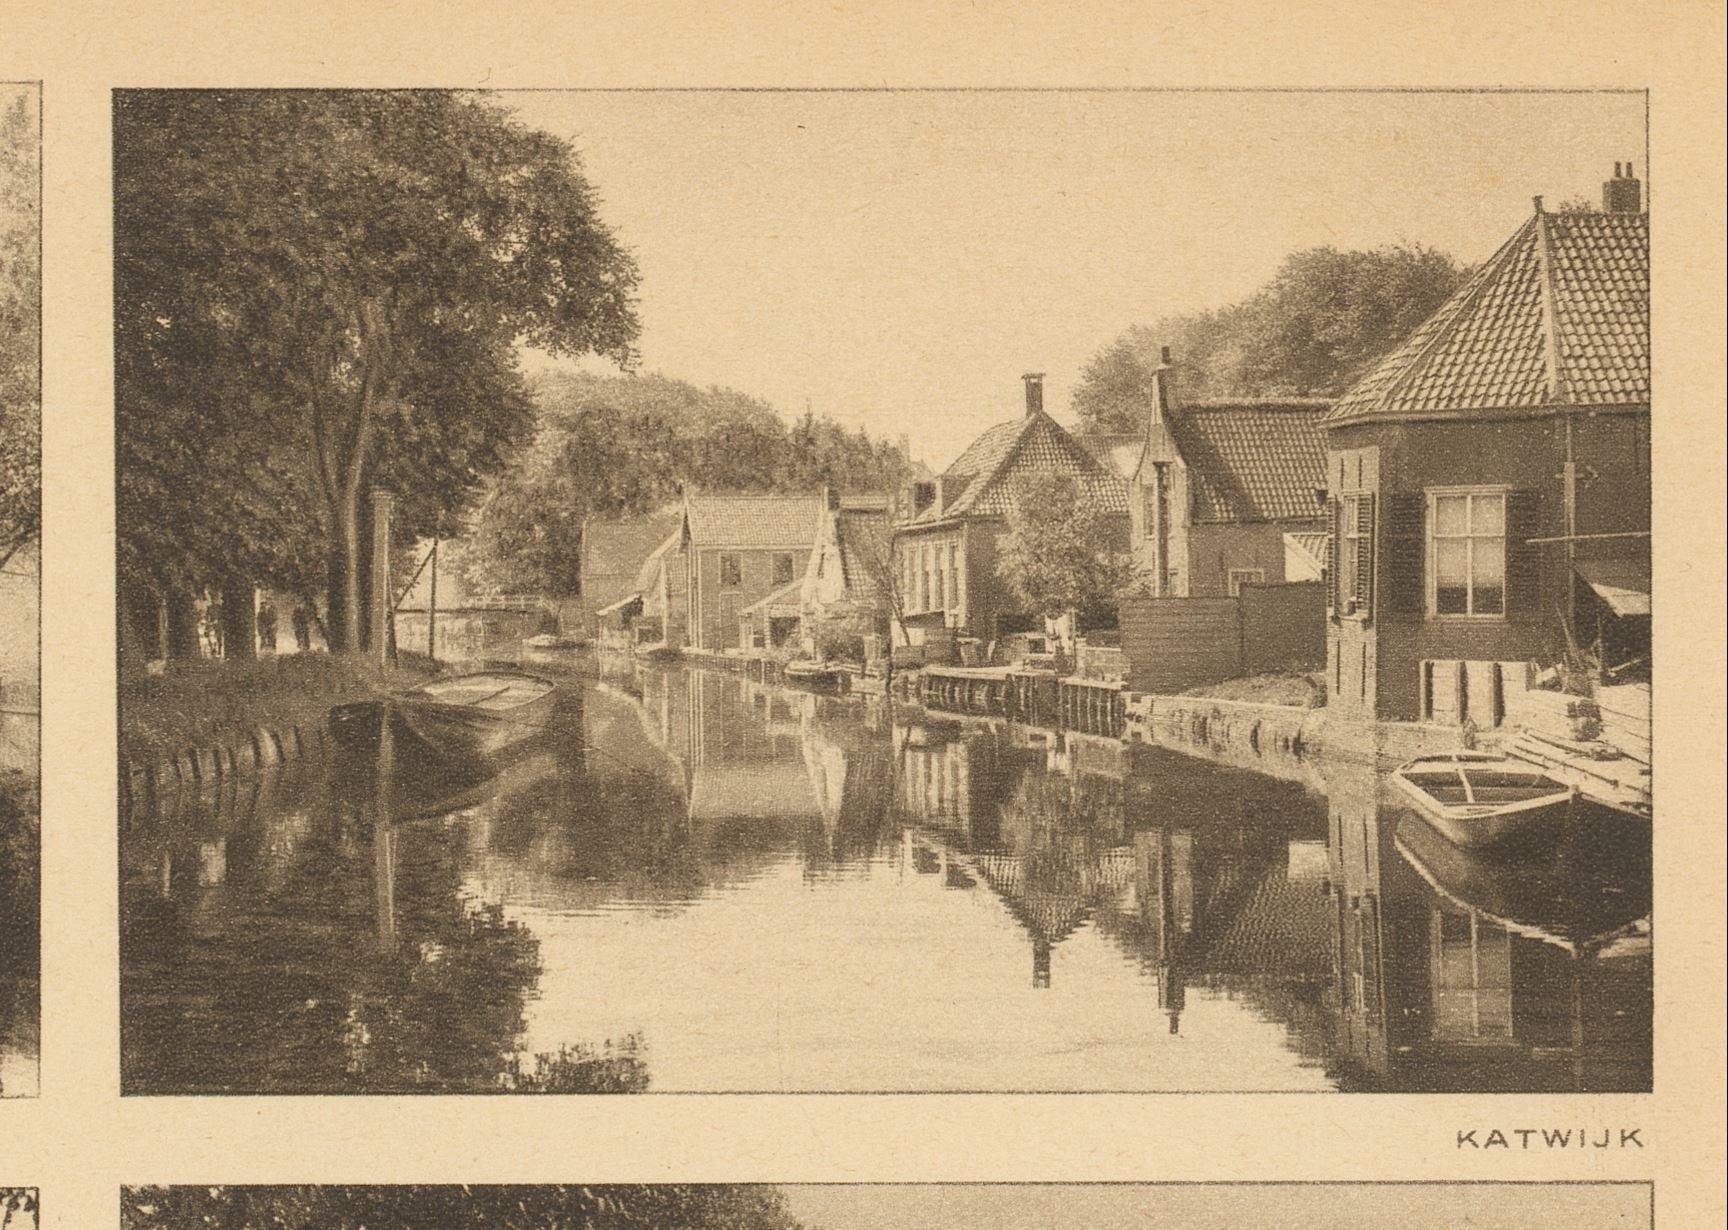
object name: photomechanical print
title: Gezicht op een rij huizen aan het water in Katwijk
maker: Anonymous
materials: paper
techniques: rotogravure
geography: katwijk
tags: canals, waters (in village), the usual house or row of houses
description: Deze prent maakt deel uit van een album.